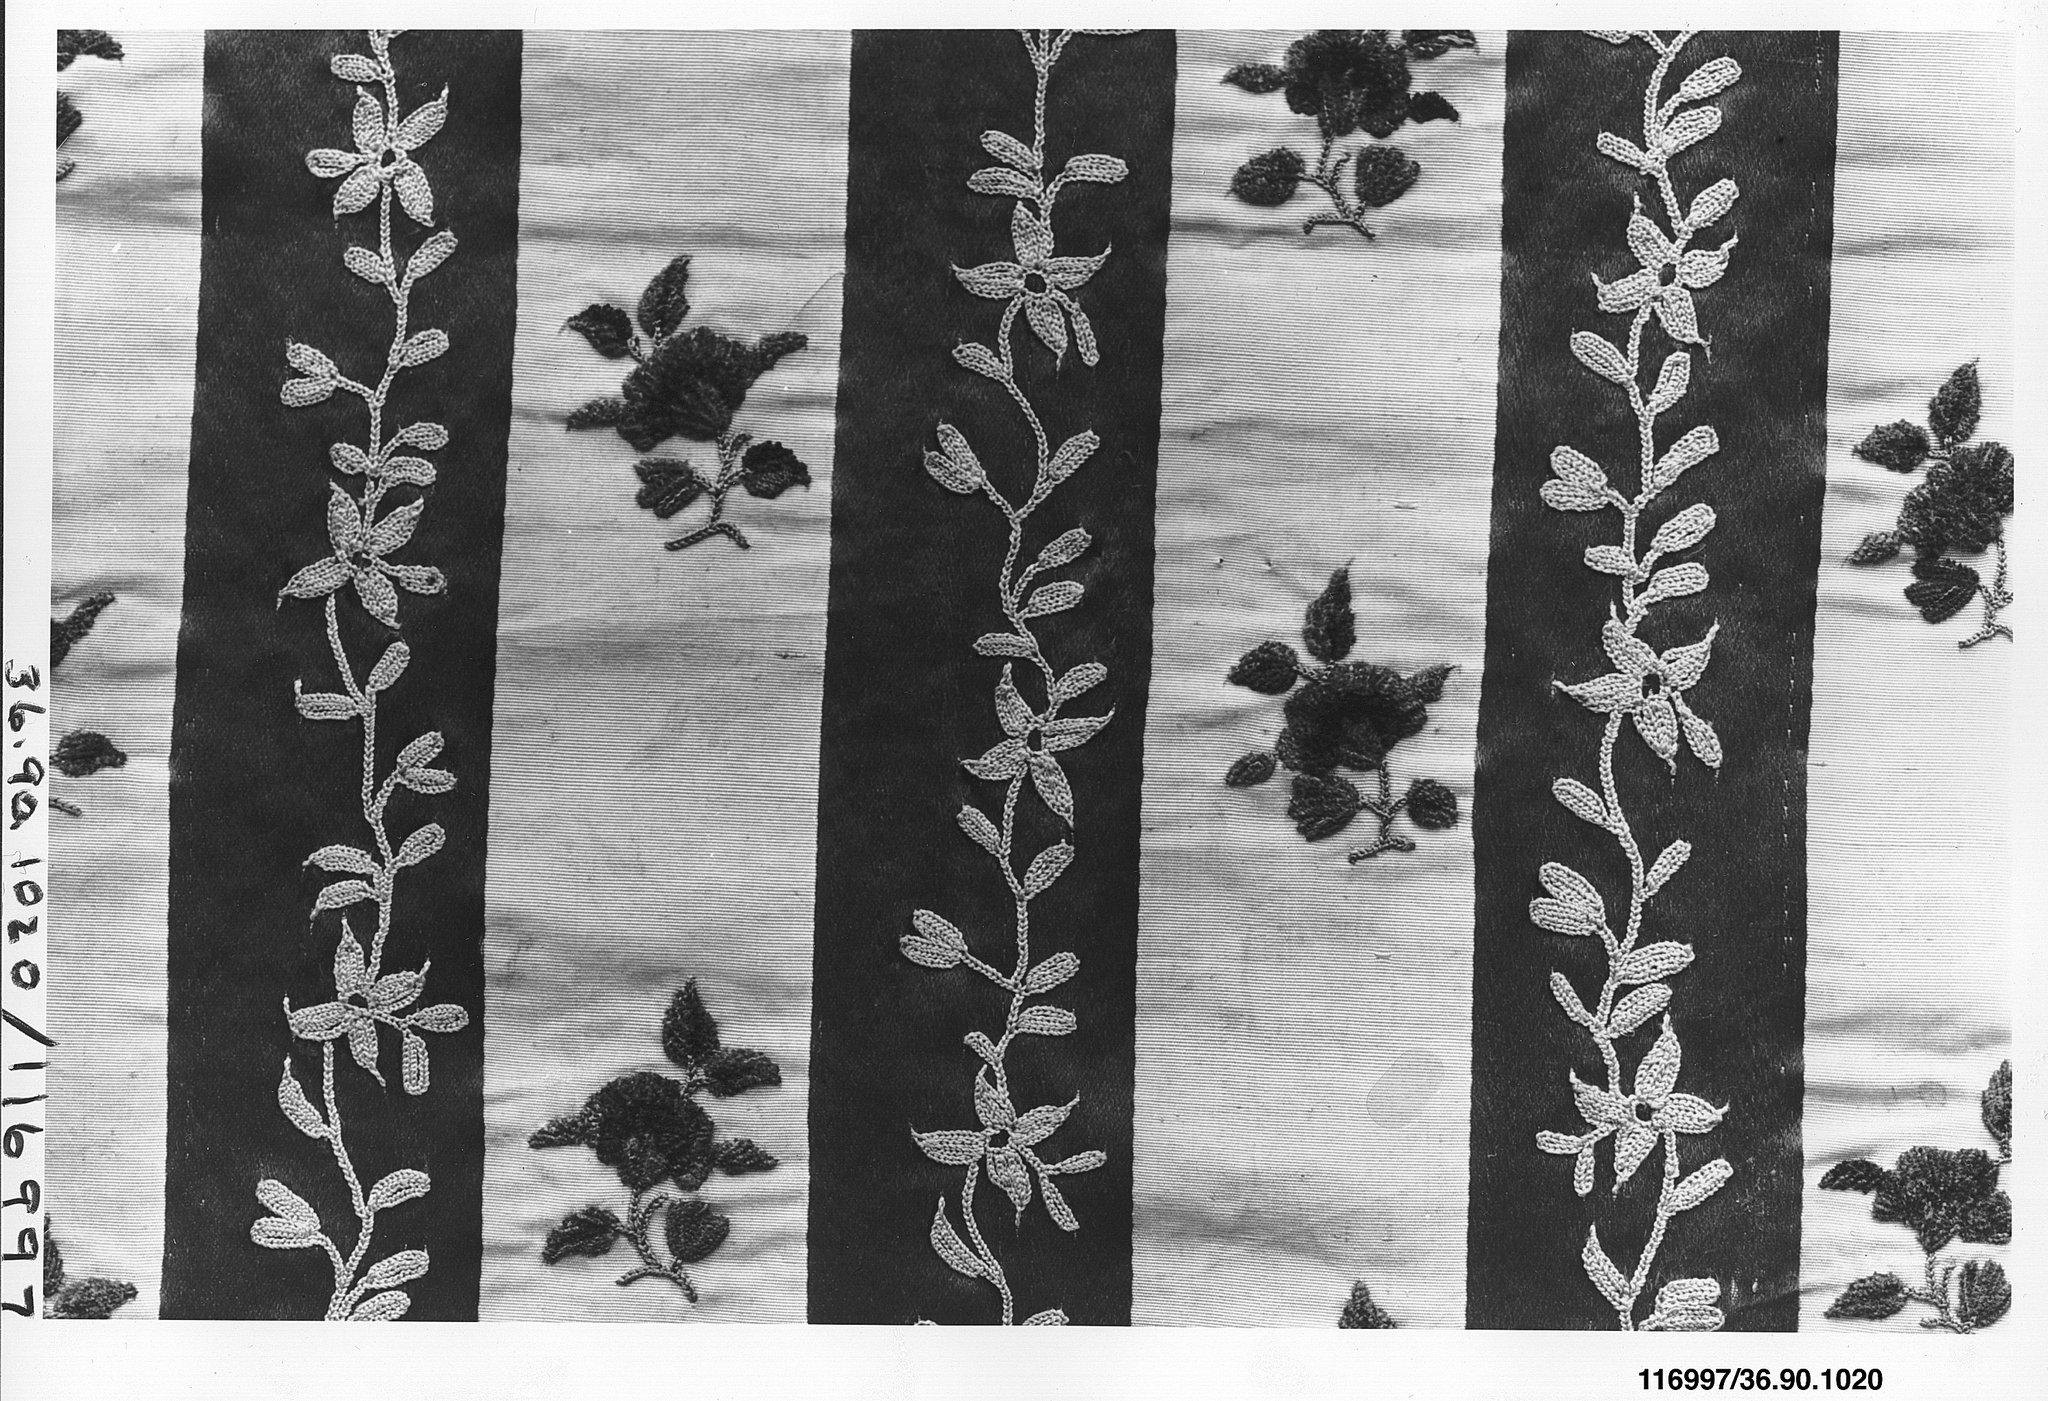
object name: piece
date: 1701-1800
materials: silk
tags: flowers